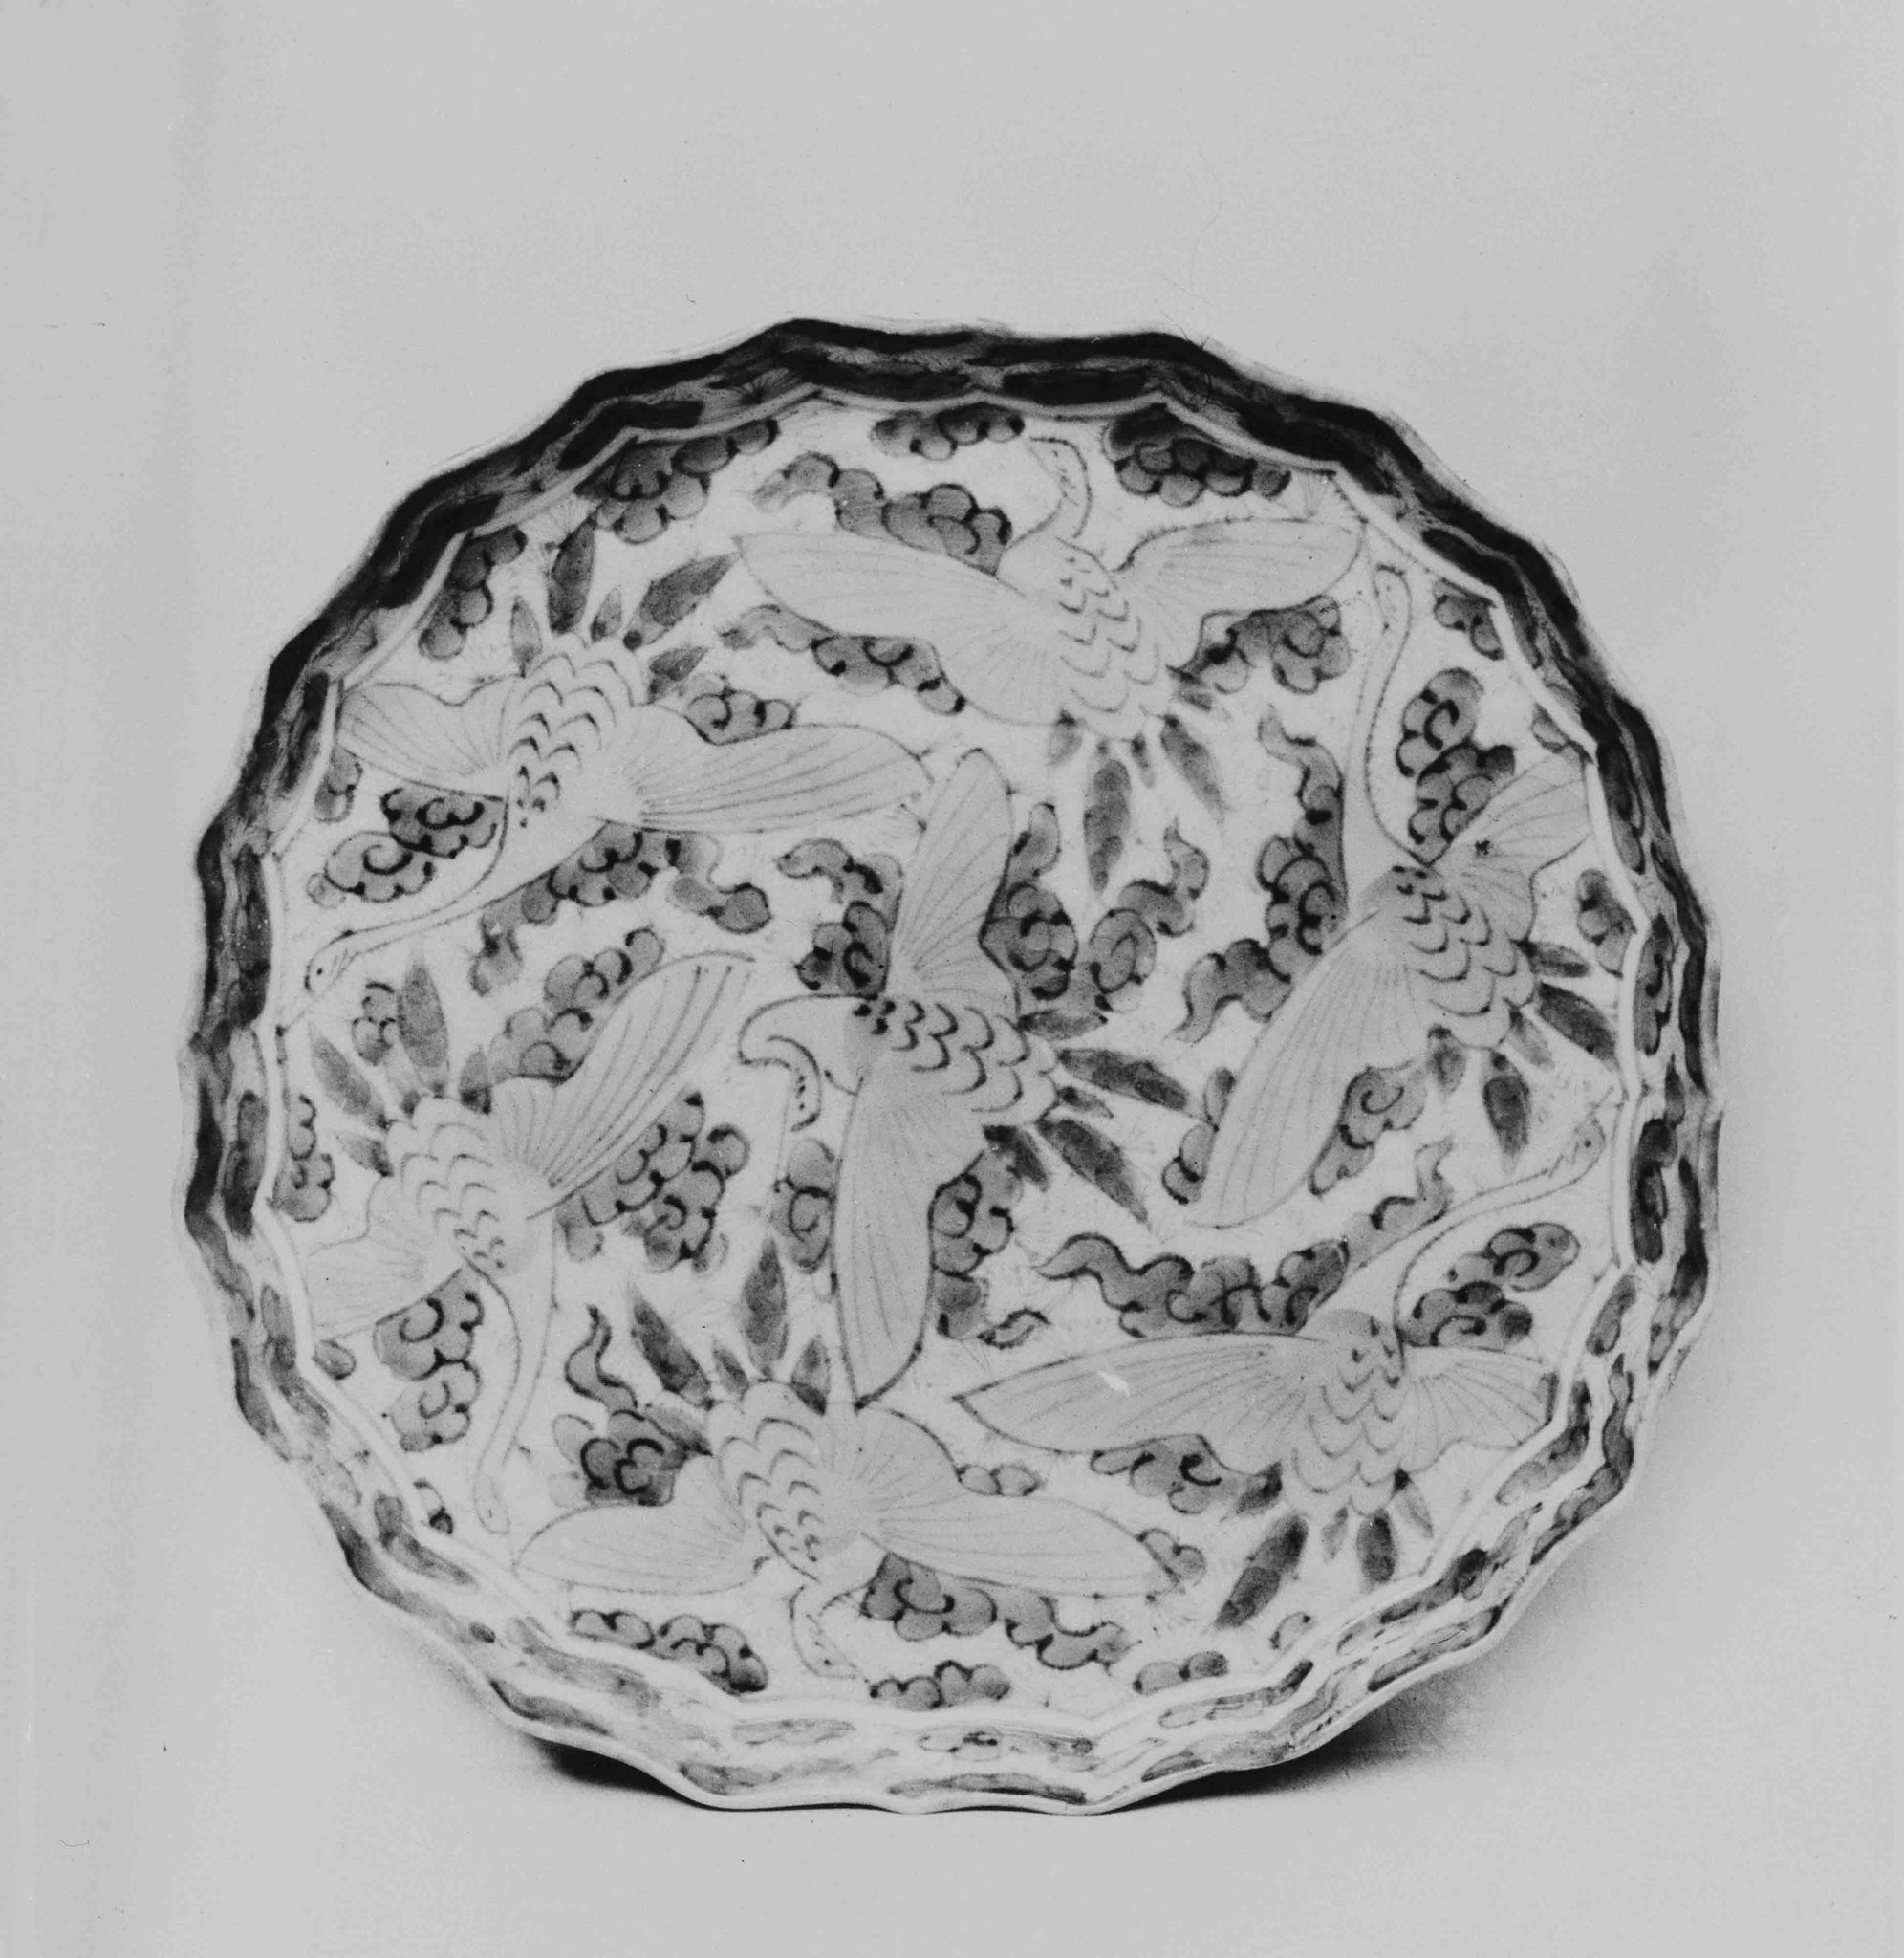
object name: plate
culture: japanese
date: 1800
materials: glaze, porcelain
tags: birds